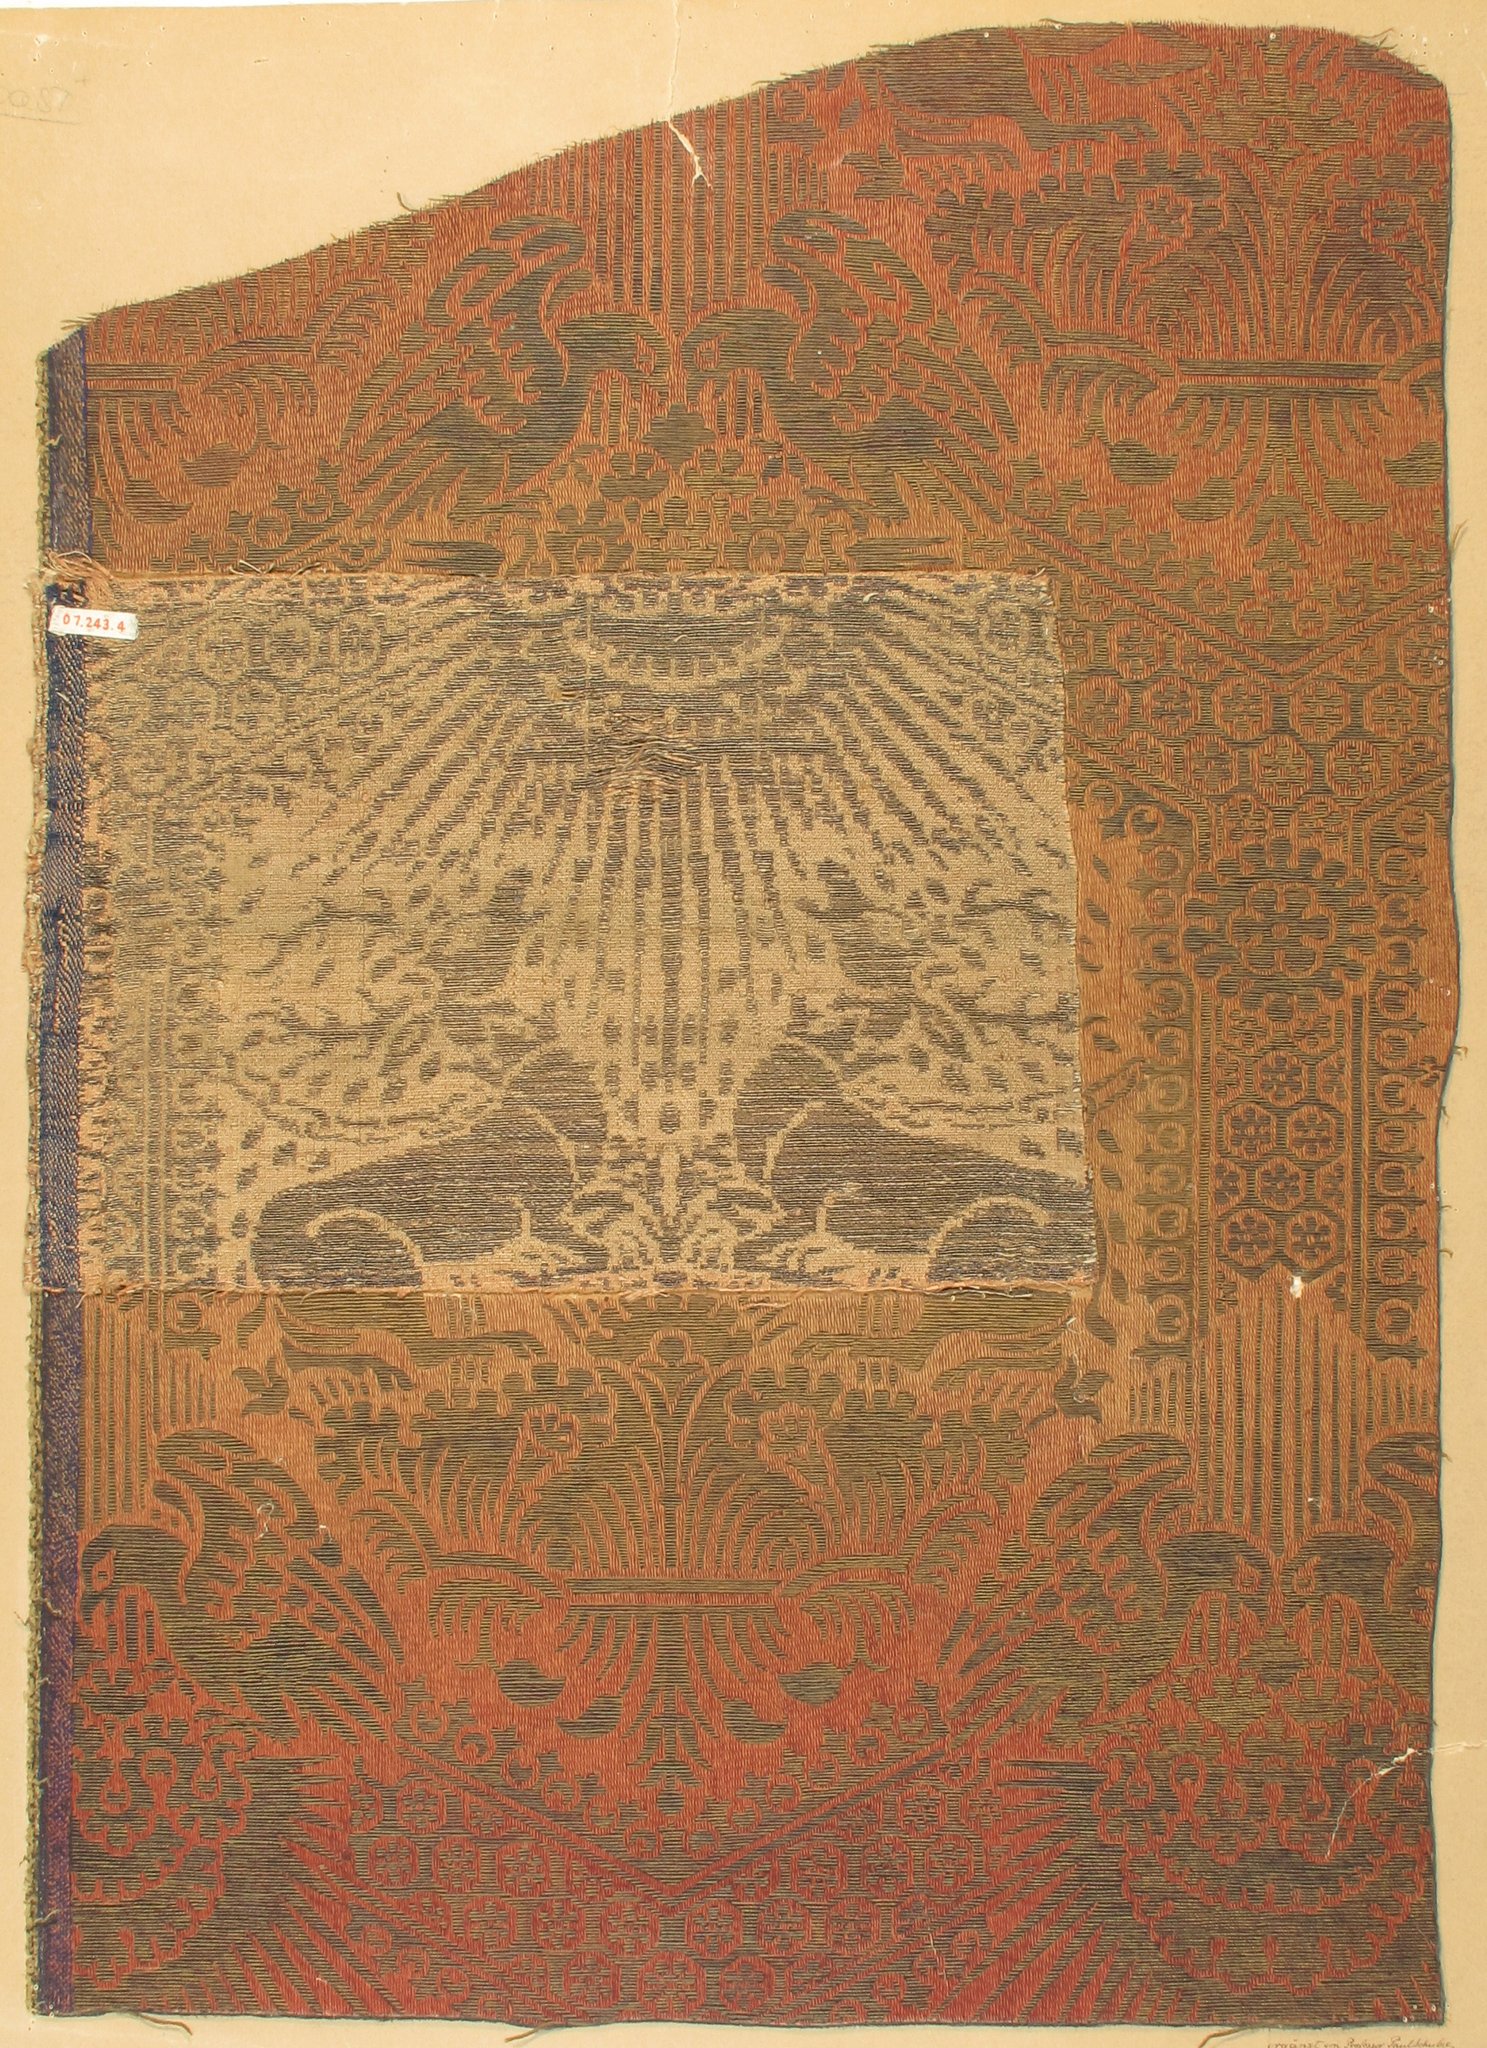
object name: textile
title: Brocade Textile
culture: italian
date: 1301-1400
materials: gold thread, silk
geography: italy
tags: deer